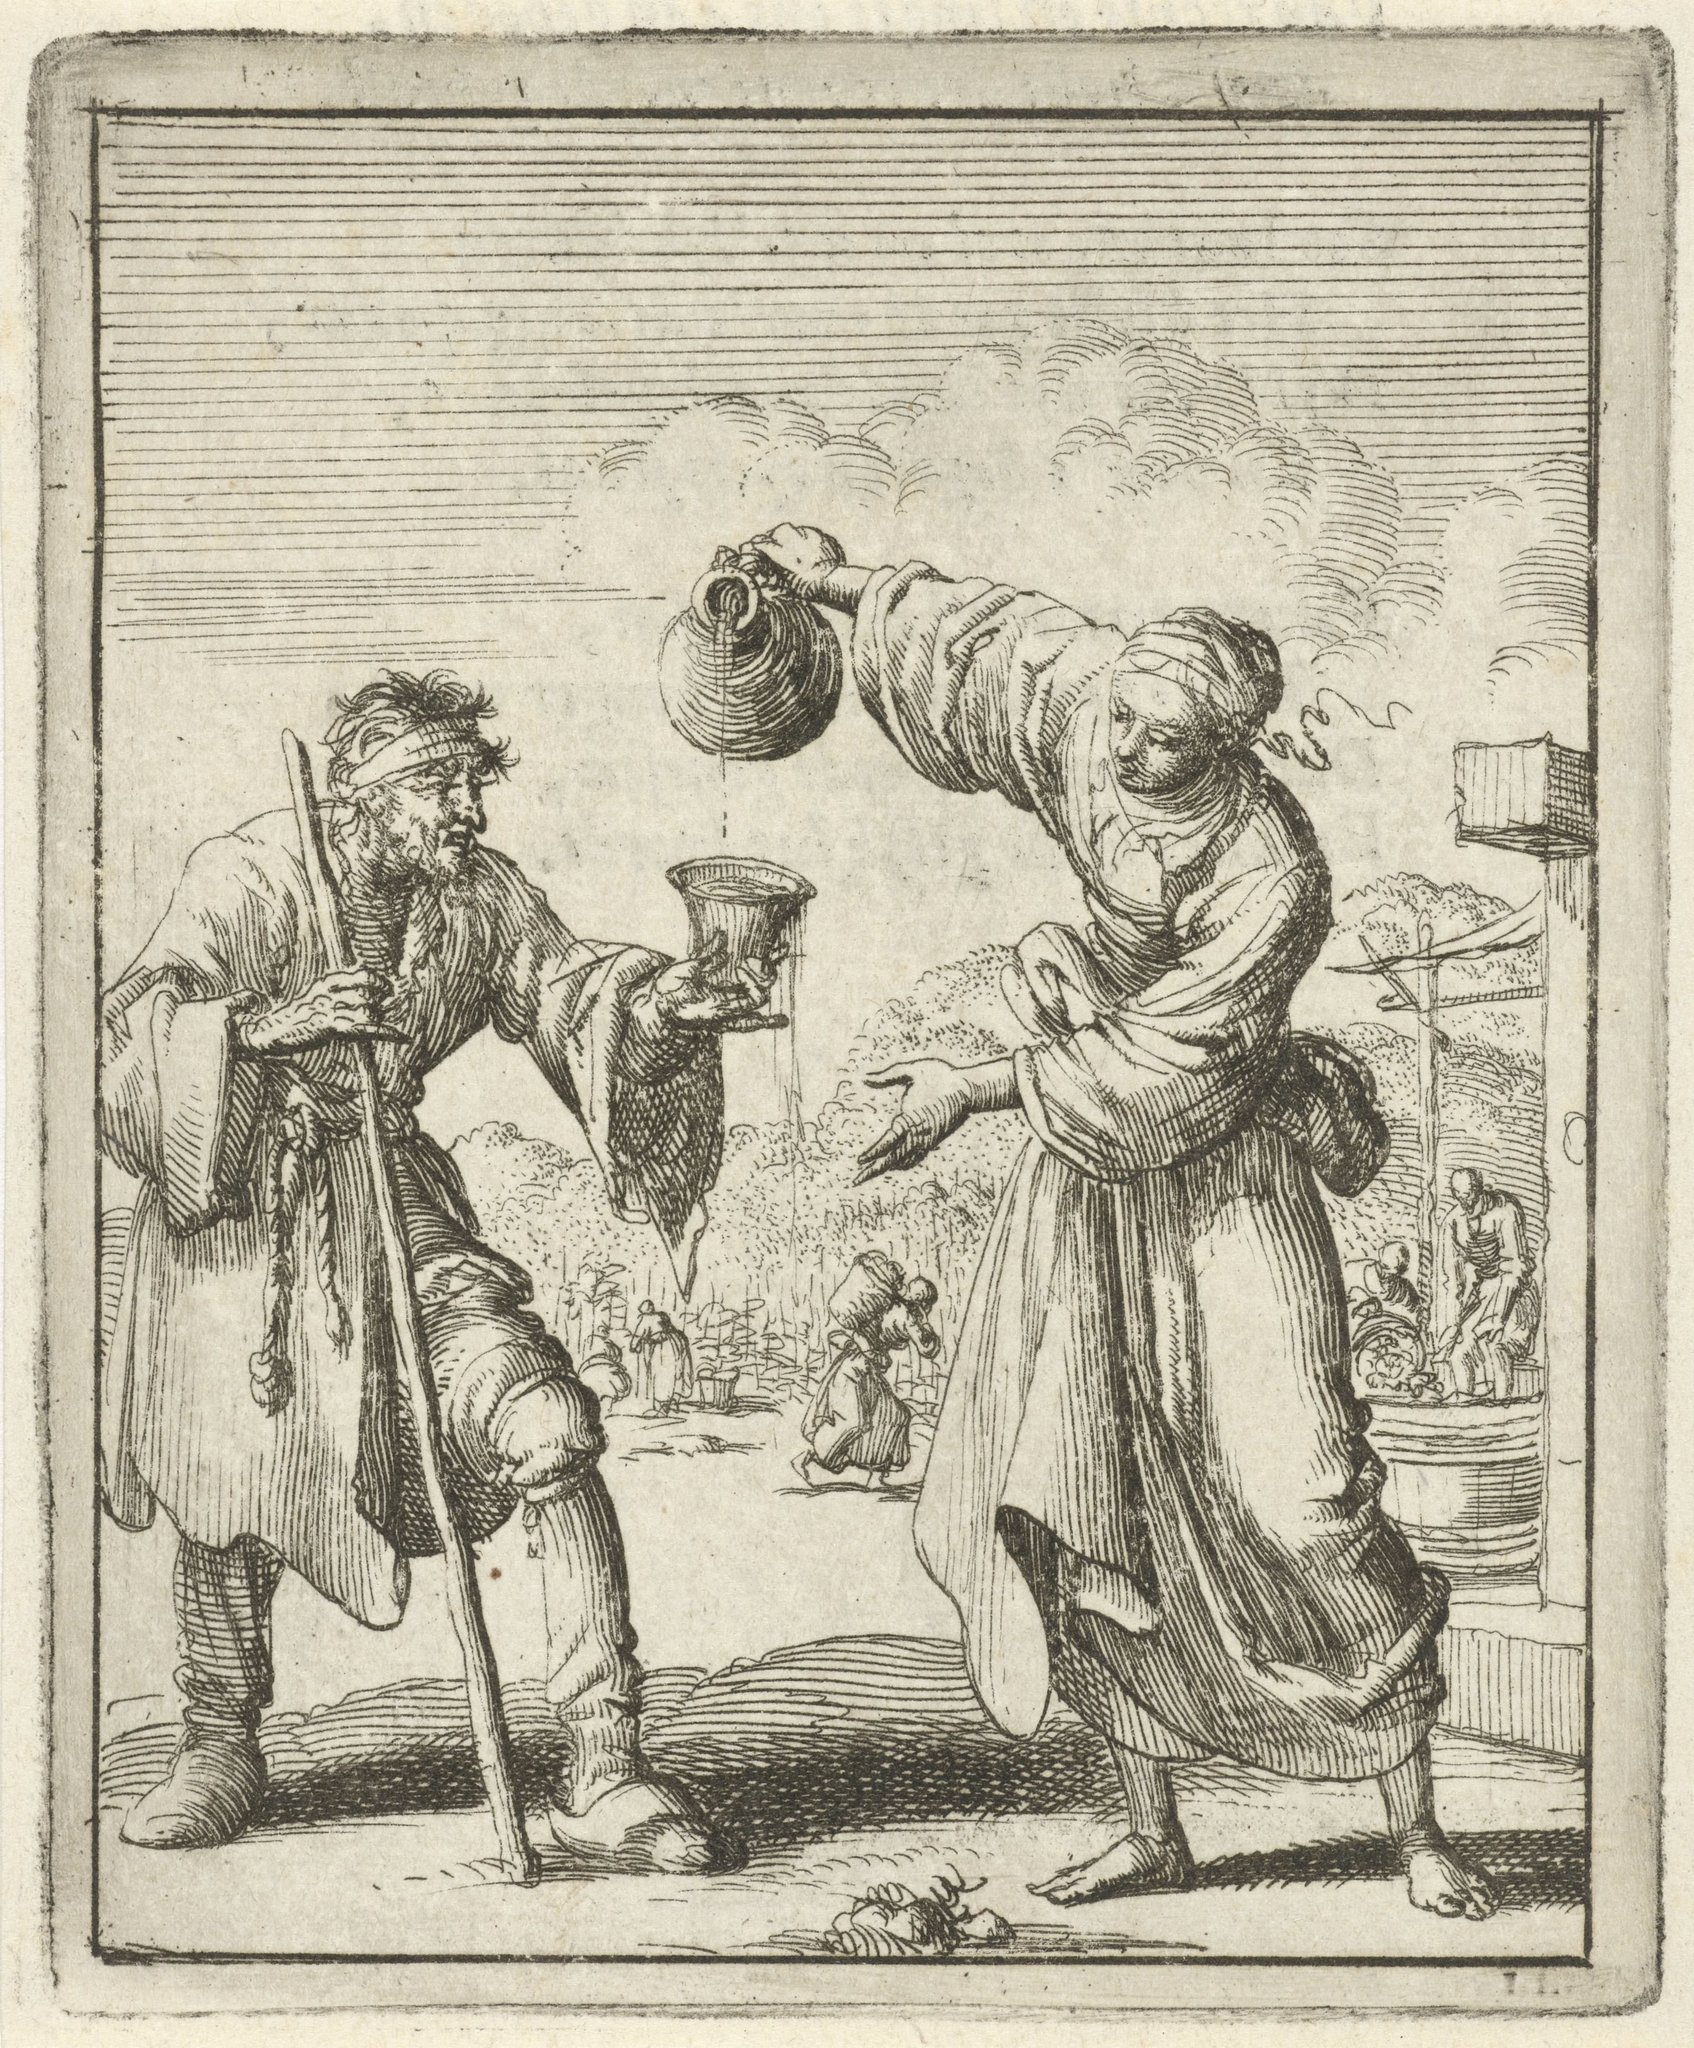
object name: print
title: Vrouw schenkt een bedelaar wijn in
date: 1687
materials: paper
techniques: etching, letterpress printing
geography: amsterdam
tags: wine ~ alcoholic drinks, beggar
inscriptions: collector's mark: Lugt 2228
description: Illustratie uit: Luyken, Jan. Voncken der liefde Jesu, van het godtbegerende zielenvier. Amsterdam: Pieter Arentsz (II), 1687, p. 68.